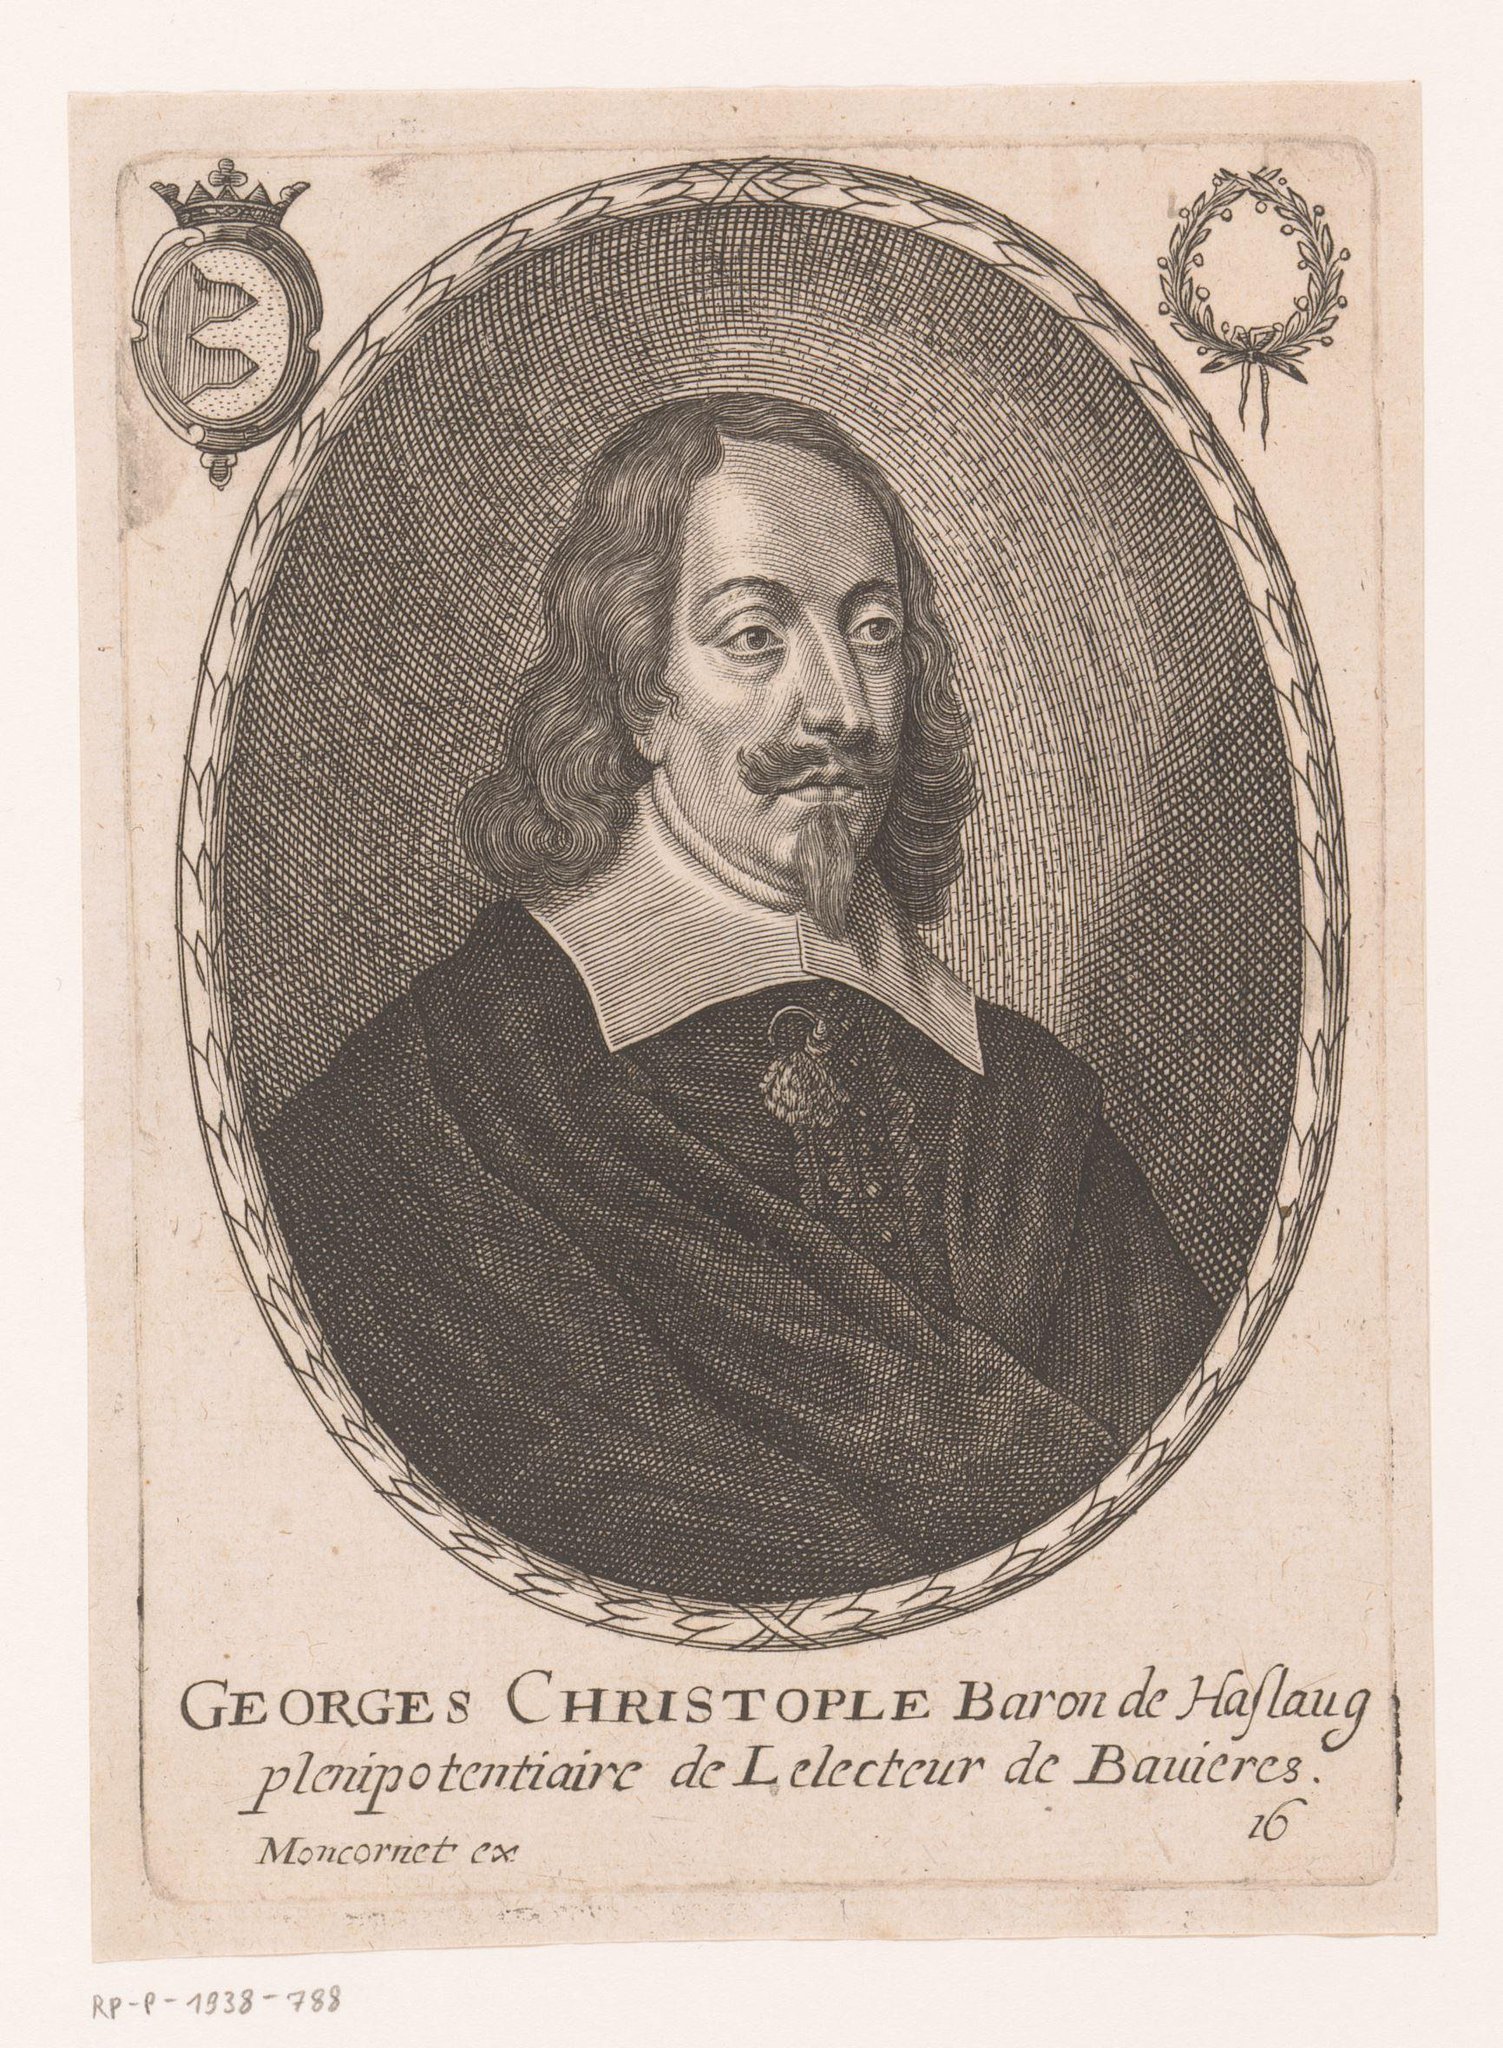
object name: print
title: Portret van Georg Christoph Von Haslang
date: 1610-1668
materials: paper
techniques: engraving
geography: france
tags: politician, historical persons, nobility and patriciate; chivalry, knighthood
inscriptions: collector's mark: Lugt 2228